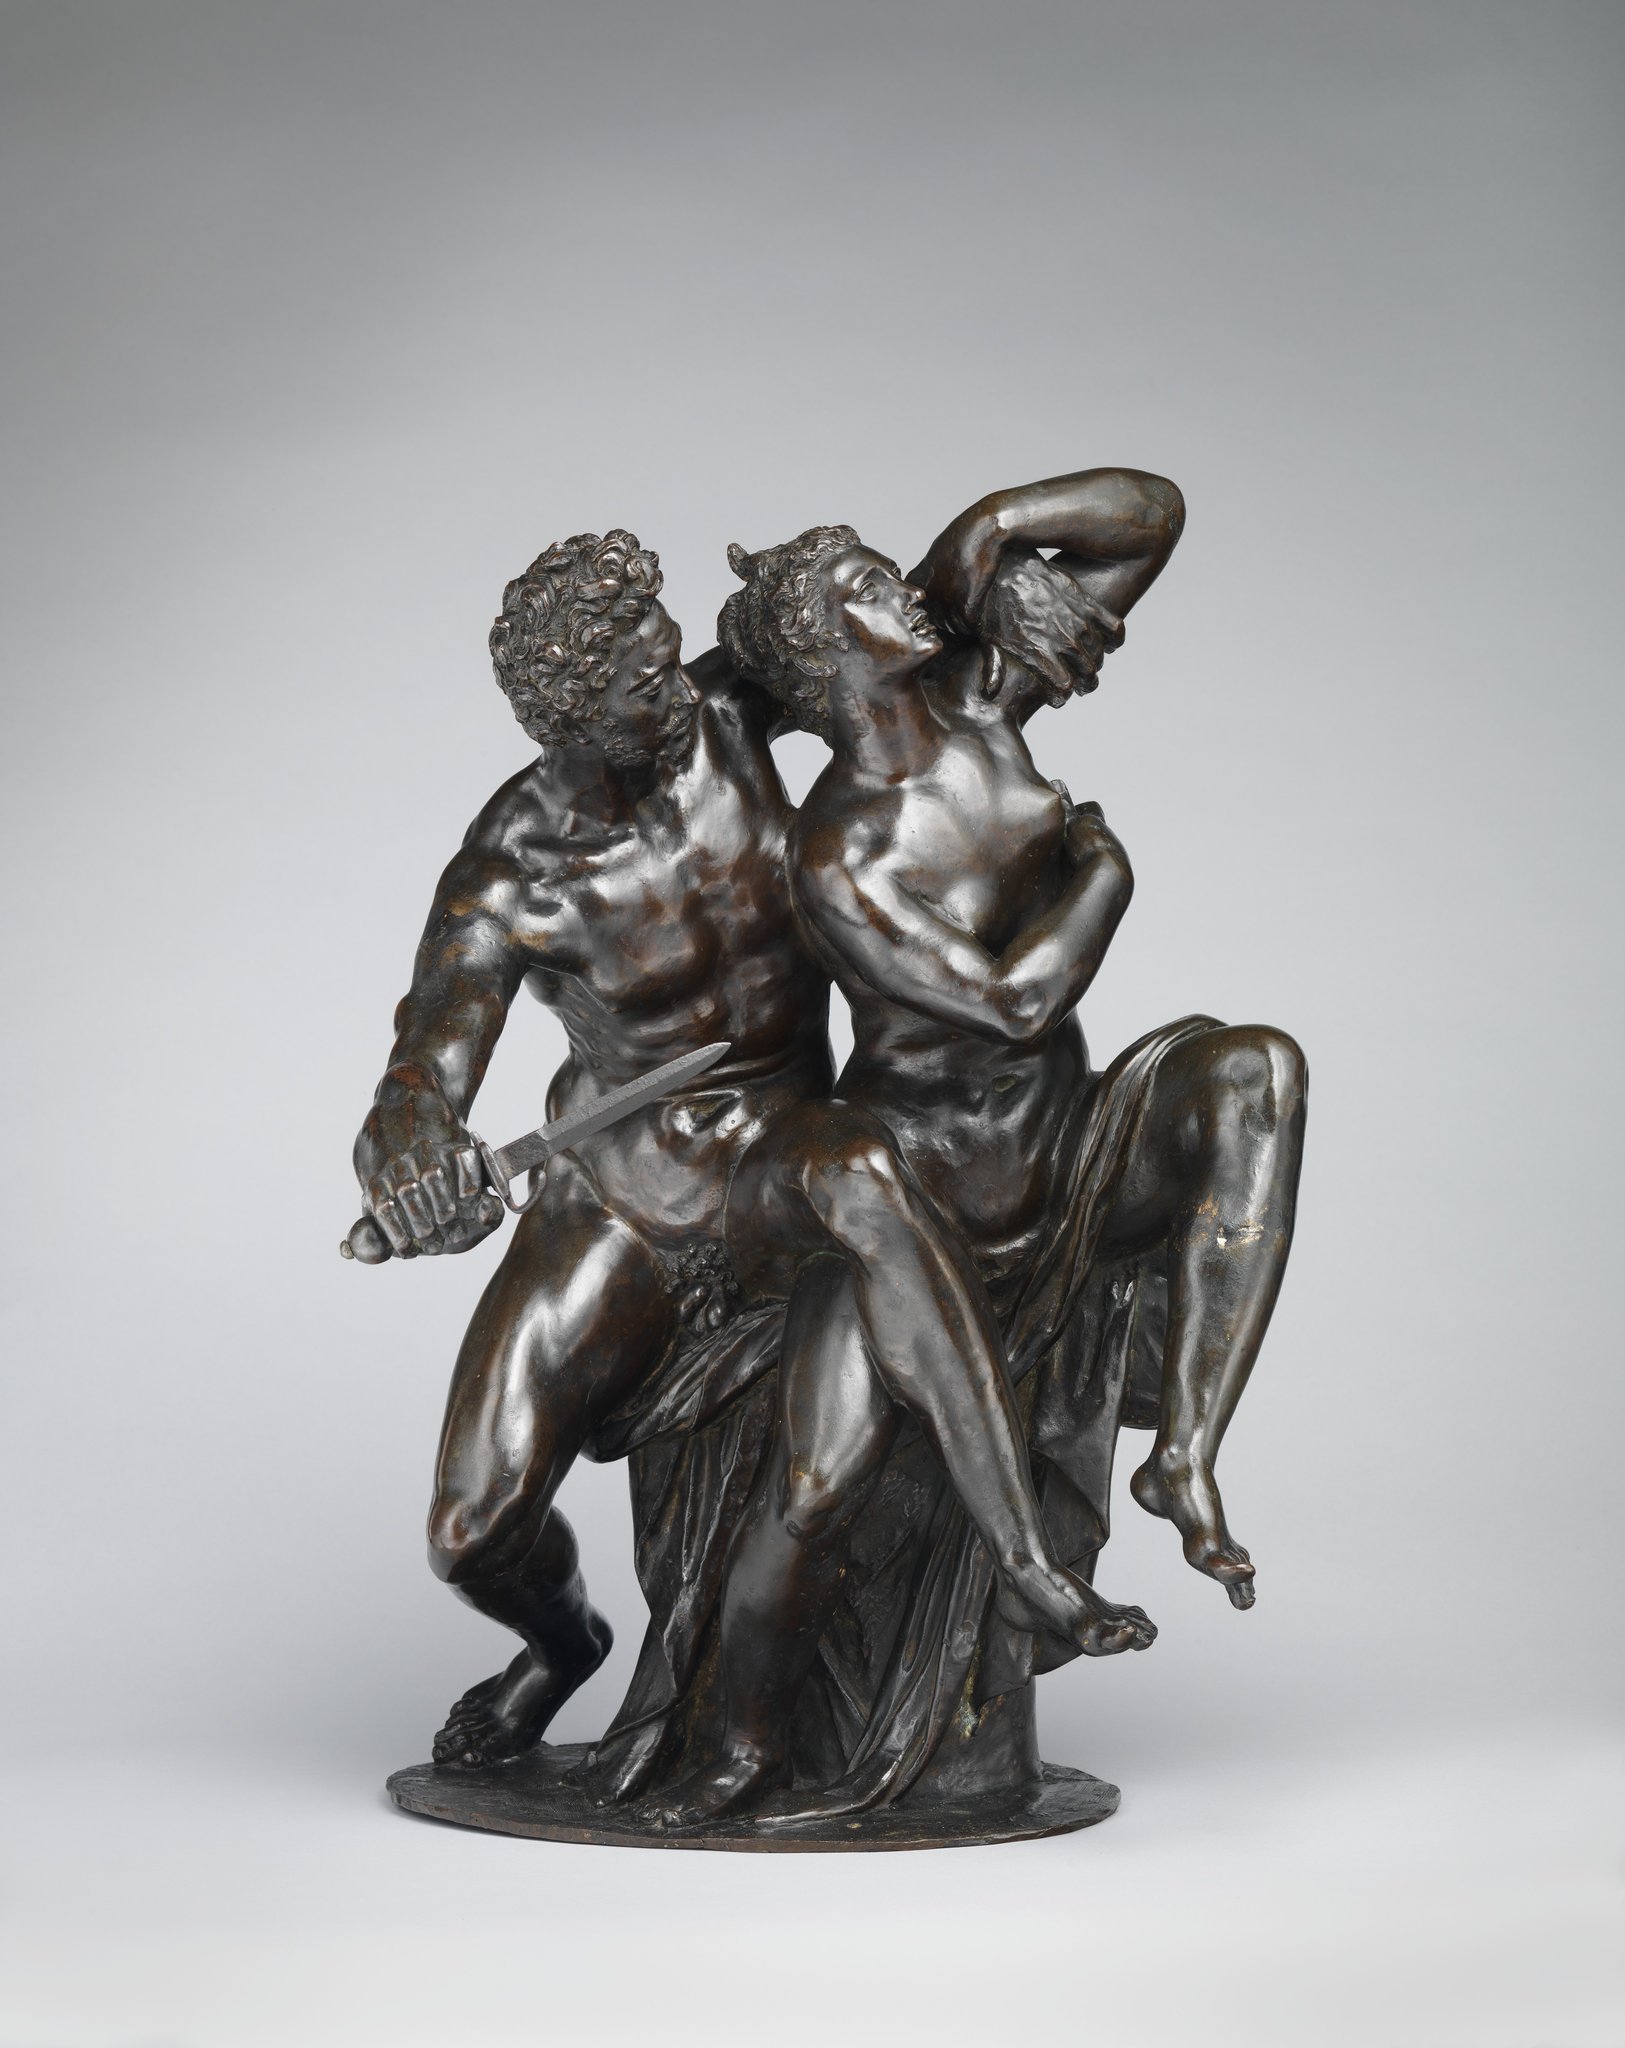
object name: statuette group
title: Tarquin and Lucretia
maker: hubert gerhard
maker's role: artist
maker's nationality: netherlandish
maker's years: 1540-1621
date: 1605-1610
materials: bronze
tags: kings,female nudes